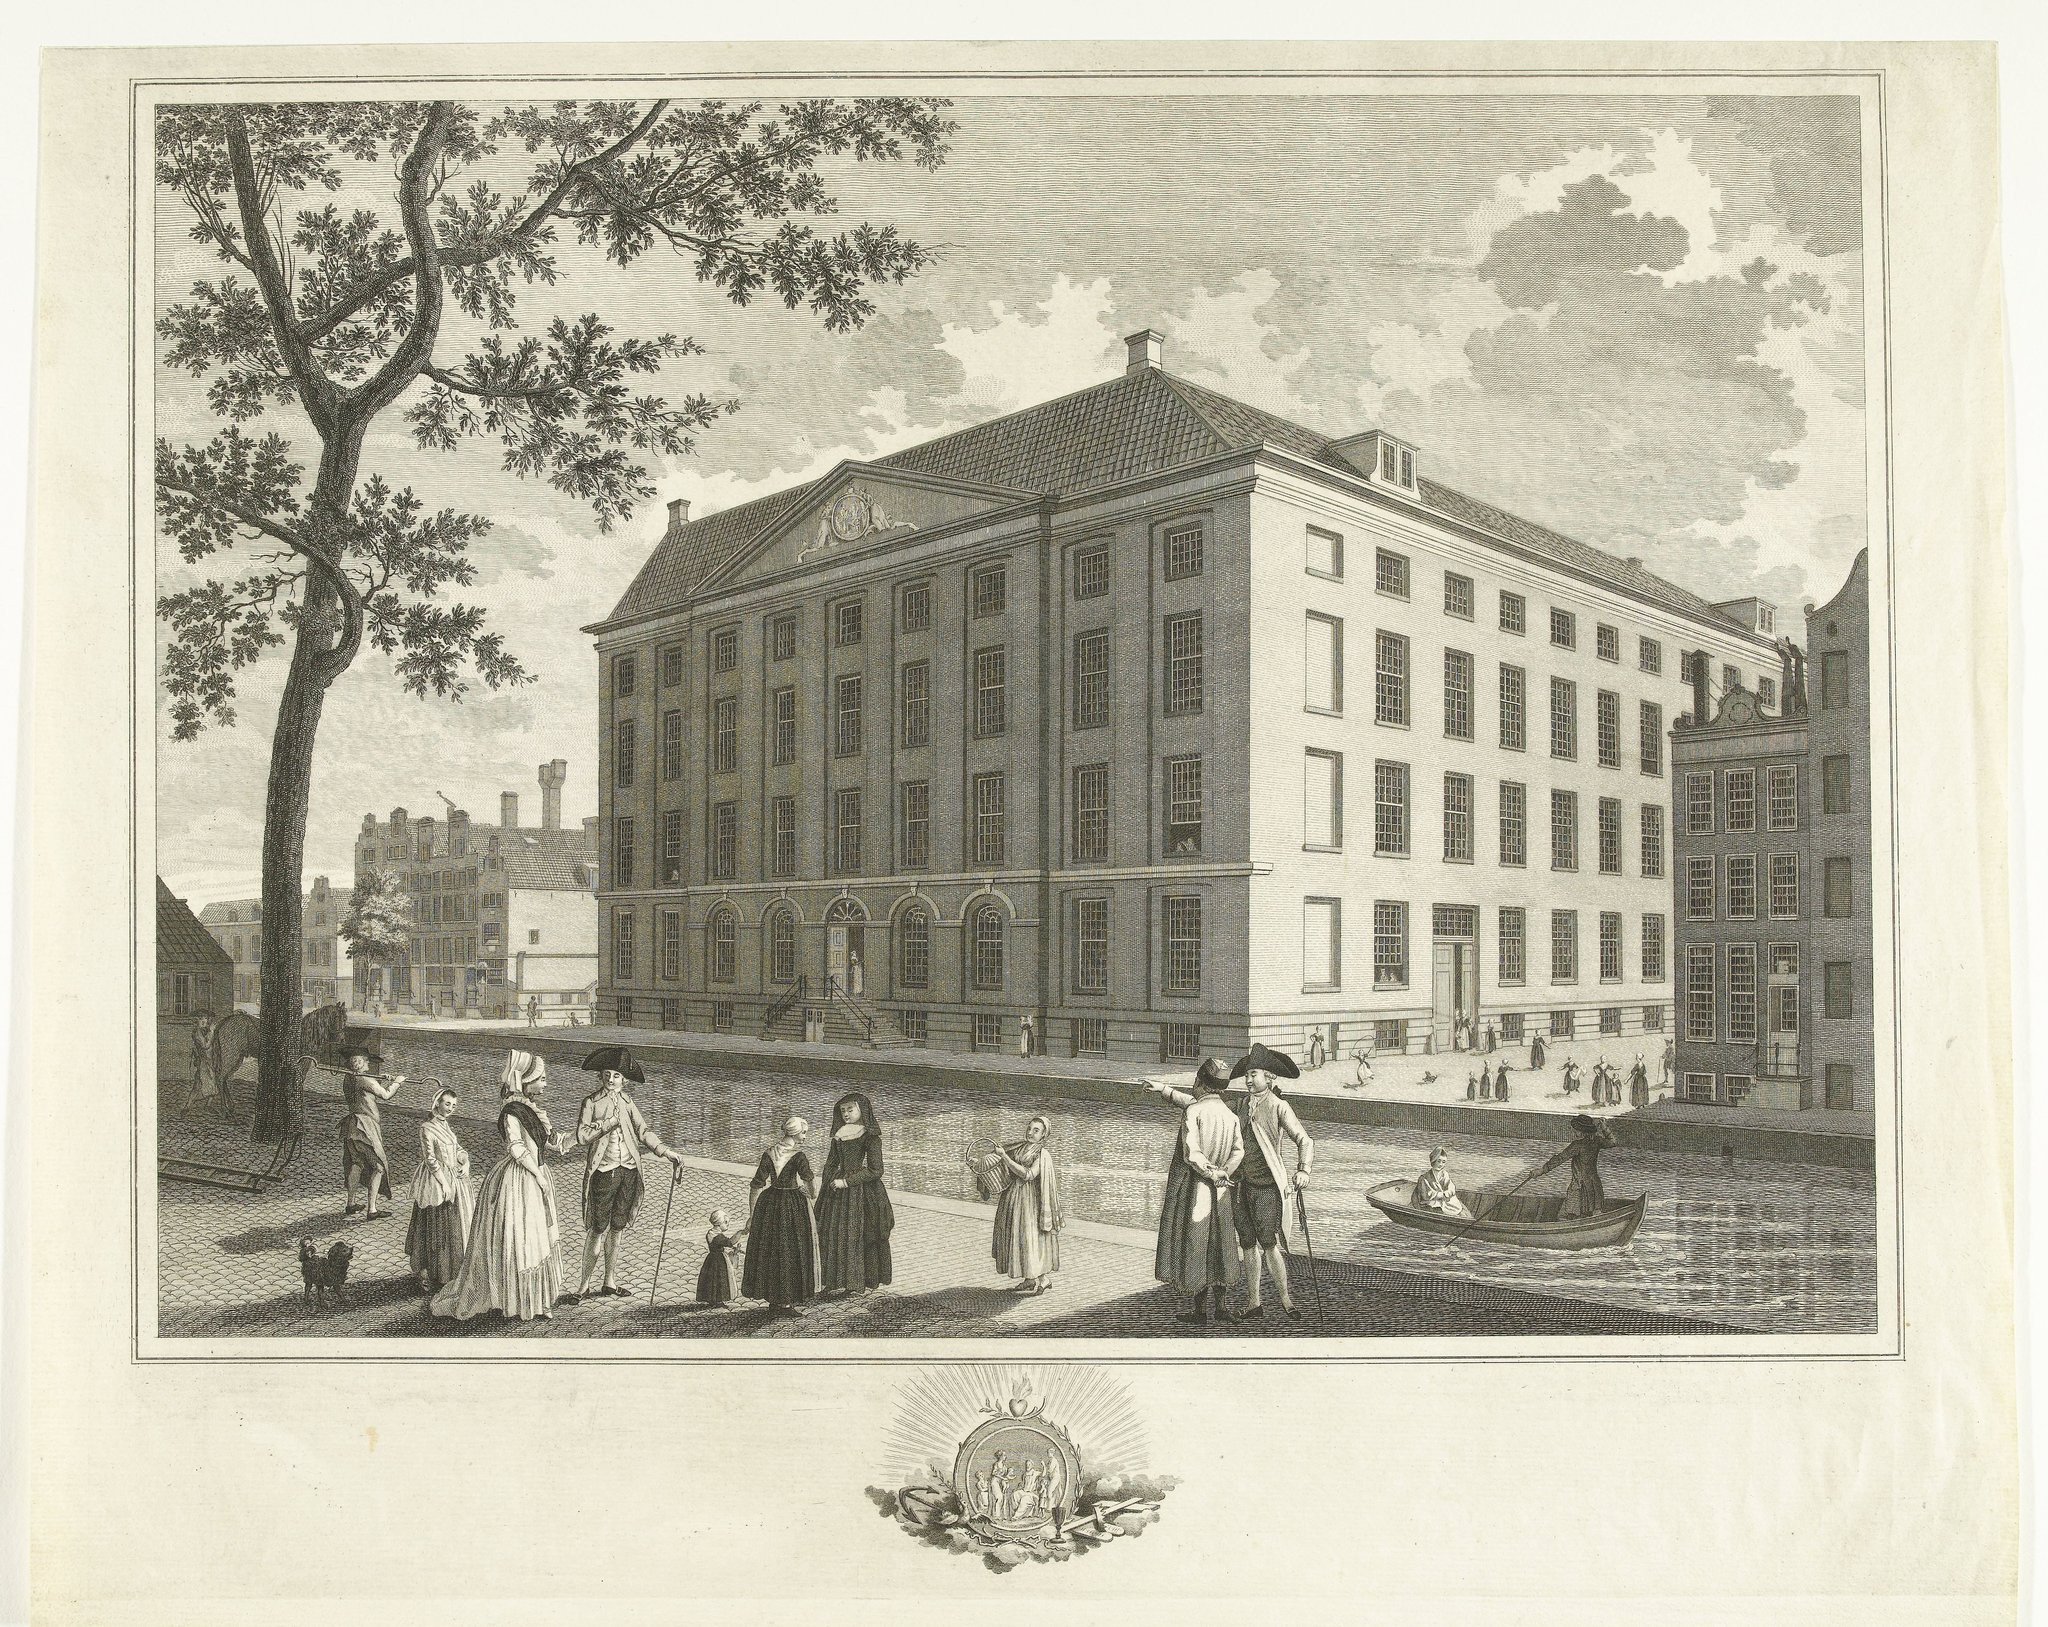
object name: print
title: Gezicht op het Maagdenhuis in Amsterdam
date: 1780-1786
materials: paper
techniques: etching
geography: amsterdam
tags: rooms-katholiek maagdenhuis (amsterdam)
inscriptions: collector's mark: Lugt 2233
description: Gezicht op het net voltooide nieuwe gebouw voor het rooms-katholieke meisjesweeshuis aan het Spui in Amsterdam. Het gebouw ligt aan een gracht en is ontworpen door Abraham van der Hart.